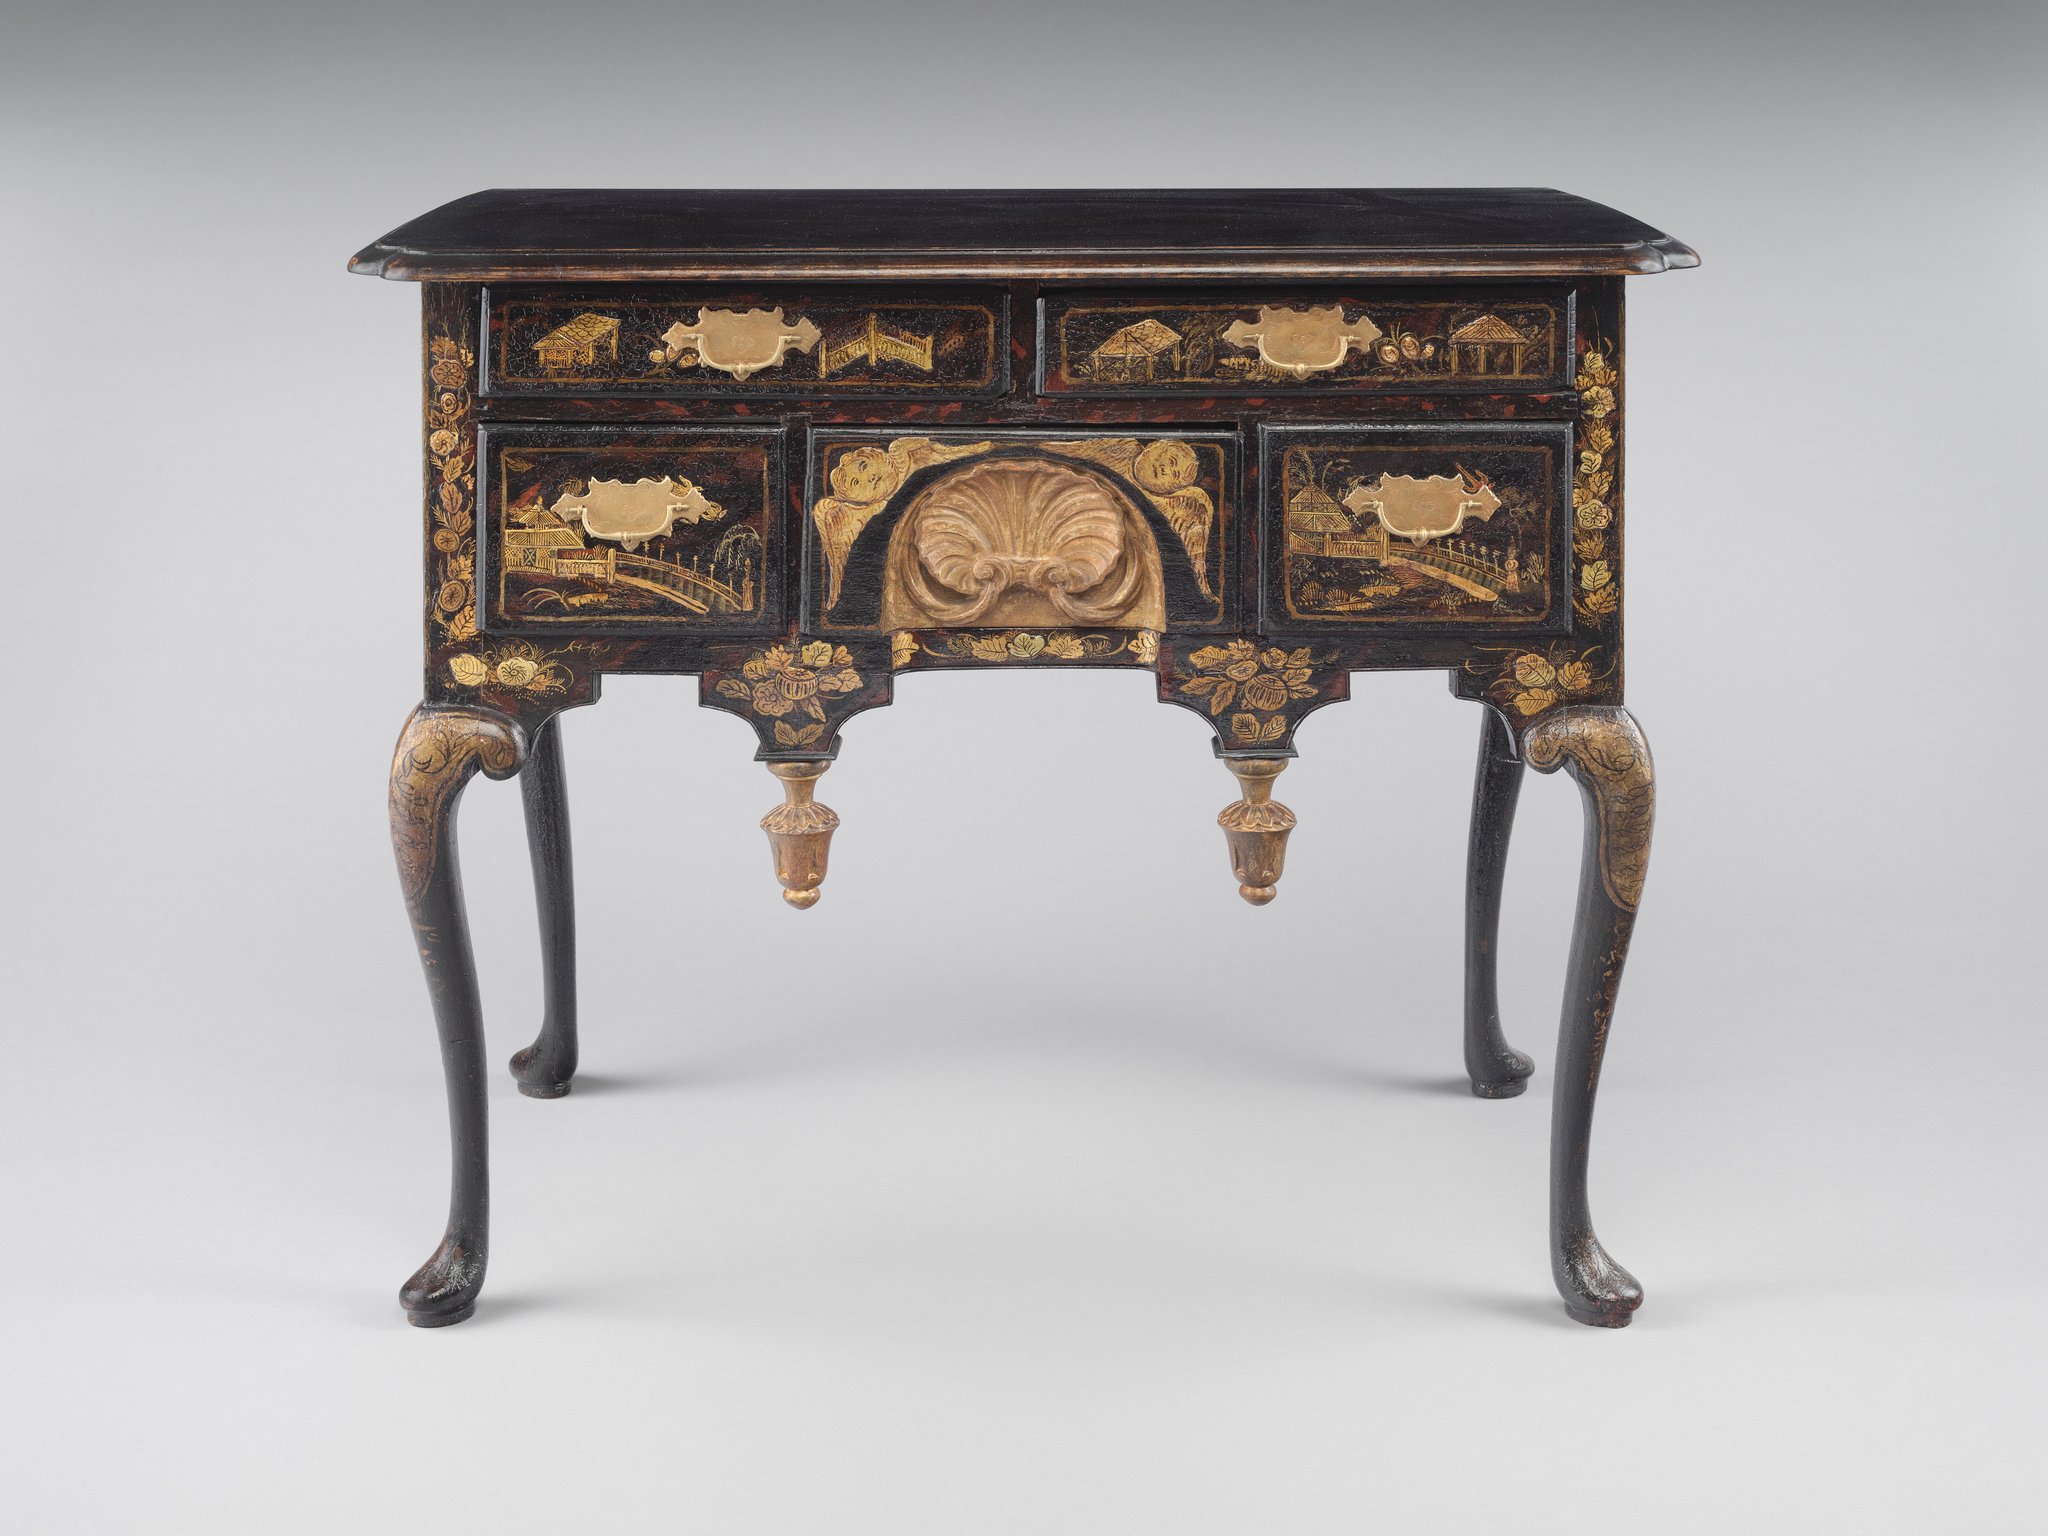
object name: dressing table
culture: american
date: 1740-1760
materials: wood, brass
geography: united states